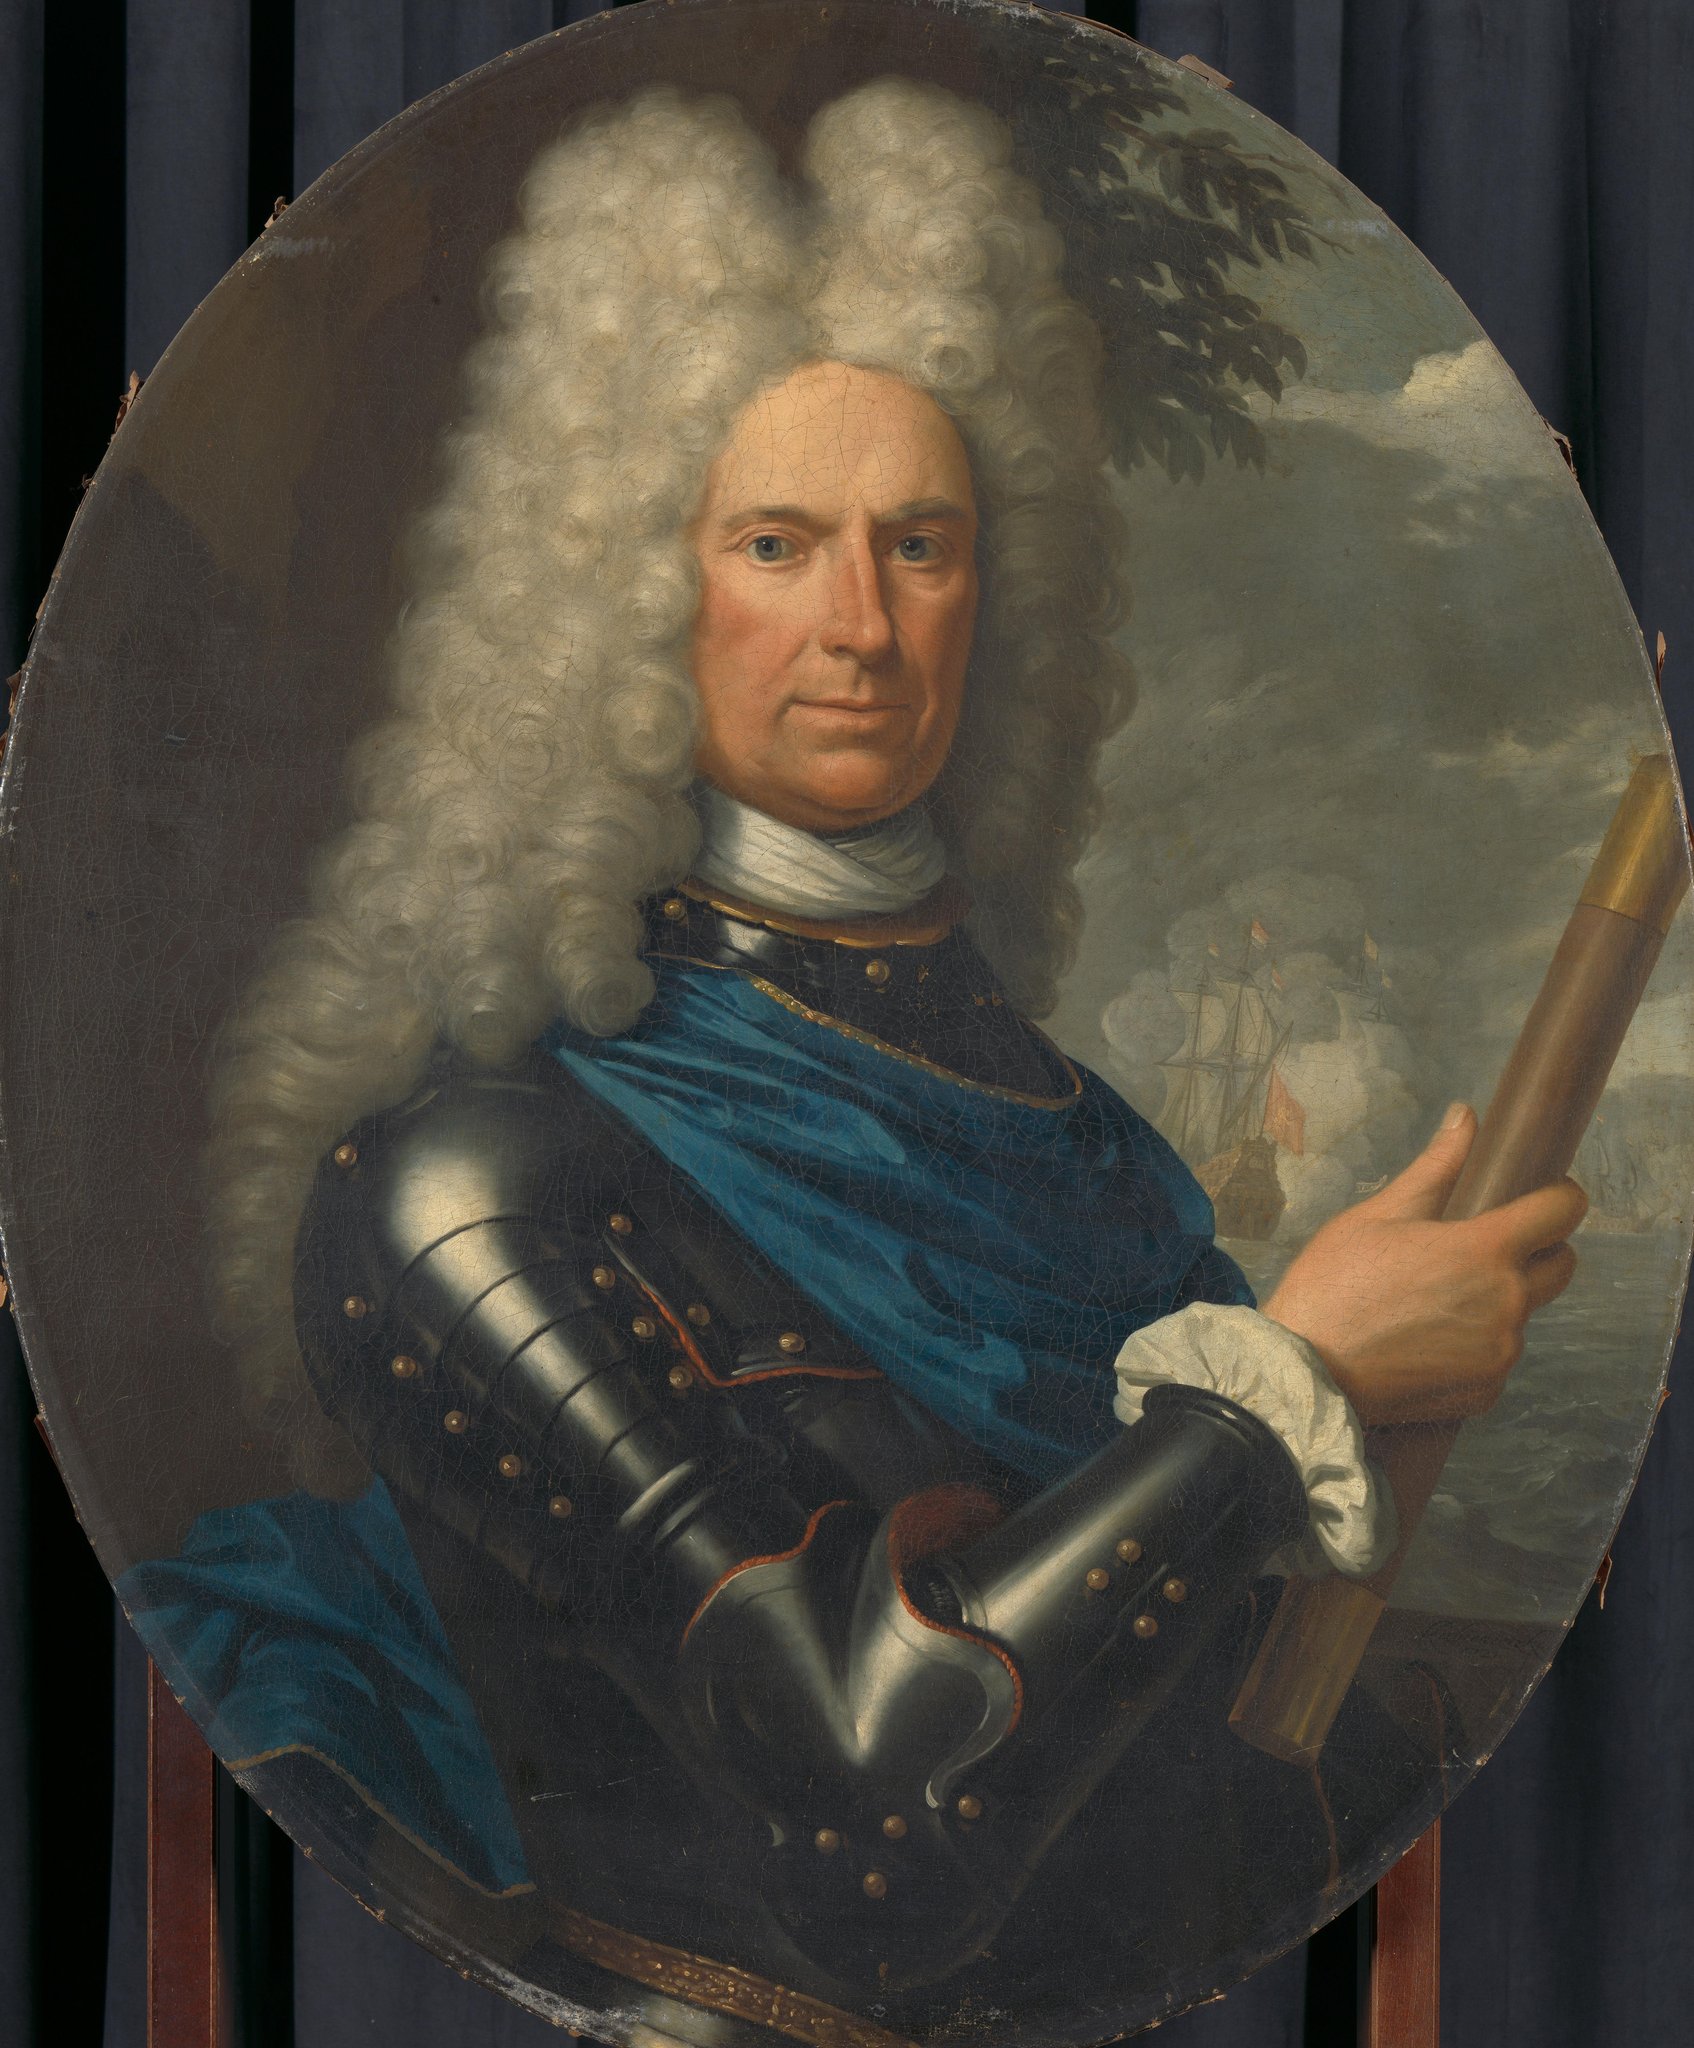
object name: painting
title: Portrait of Rear-Admiral Arent van Buren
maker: christoffel lubienitzki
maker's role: draughtsman, painter, print maker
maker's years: 1659-1729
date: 1721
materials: canvas, oil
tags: historical persons, officer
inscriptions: signature and date: ‘C. Lubienietzki 1721’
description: Portret van Arent van Buren, kapitein ter zee. Buste, in ovaal, in wapenrusting met commandostaf of telescoop in de rechterhand. Op de achtergrond een zeeslag. Pendant van SK-A-1551.